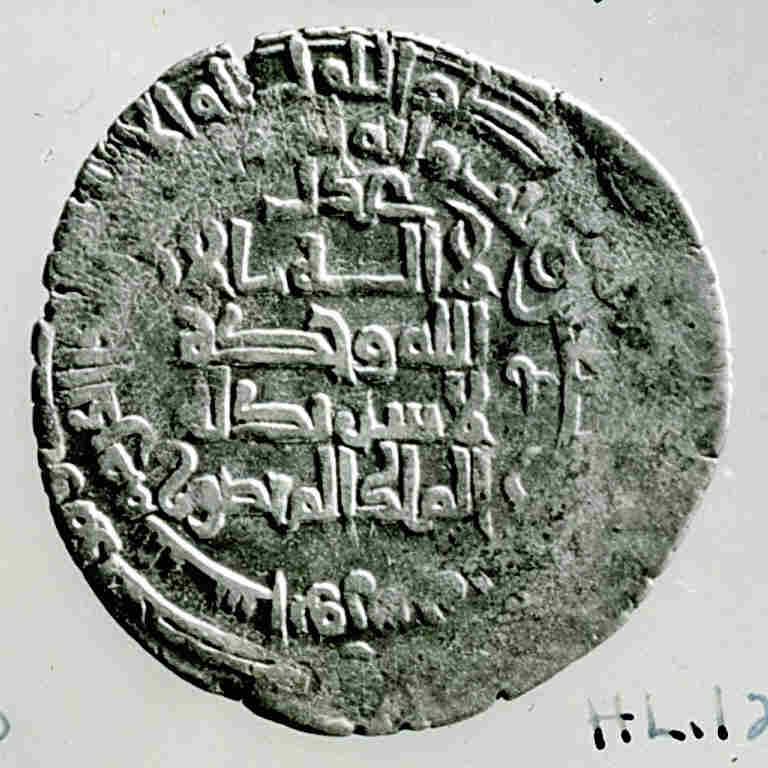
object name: coin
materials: silver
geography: iran